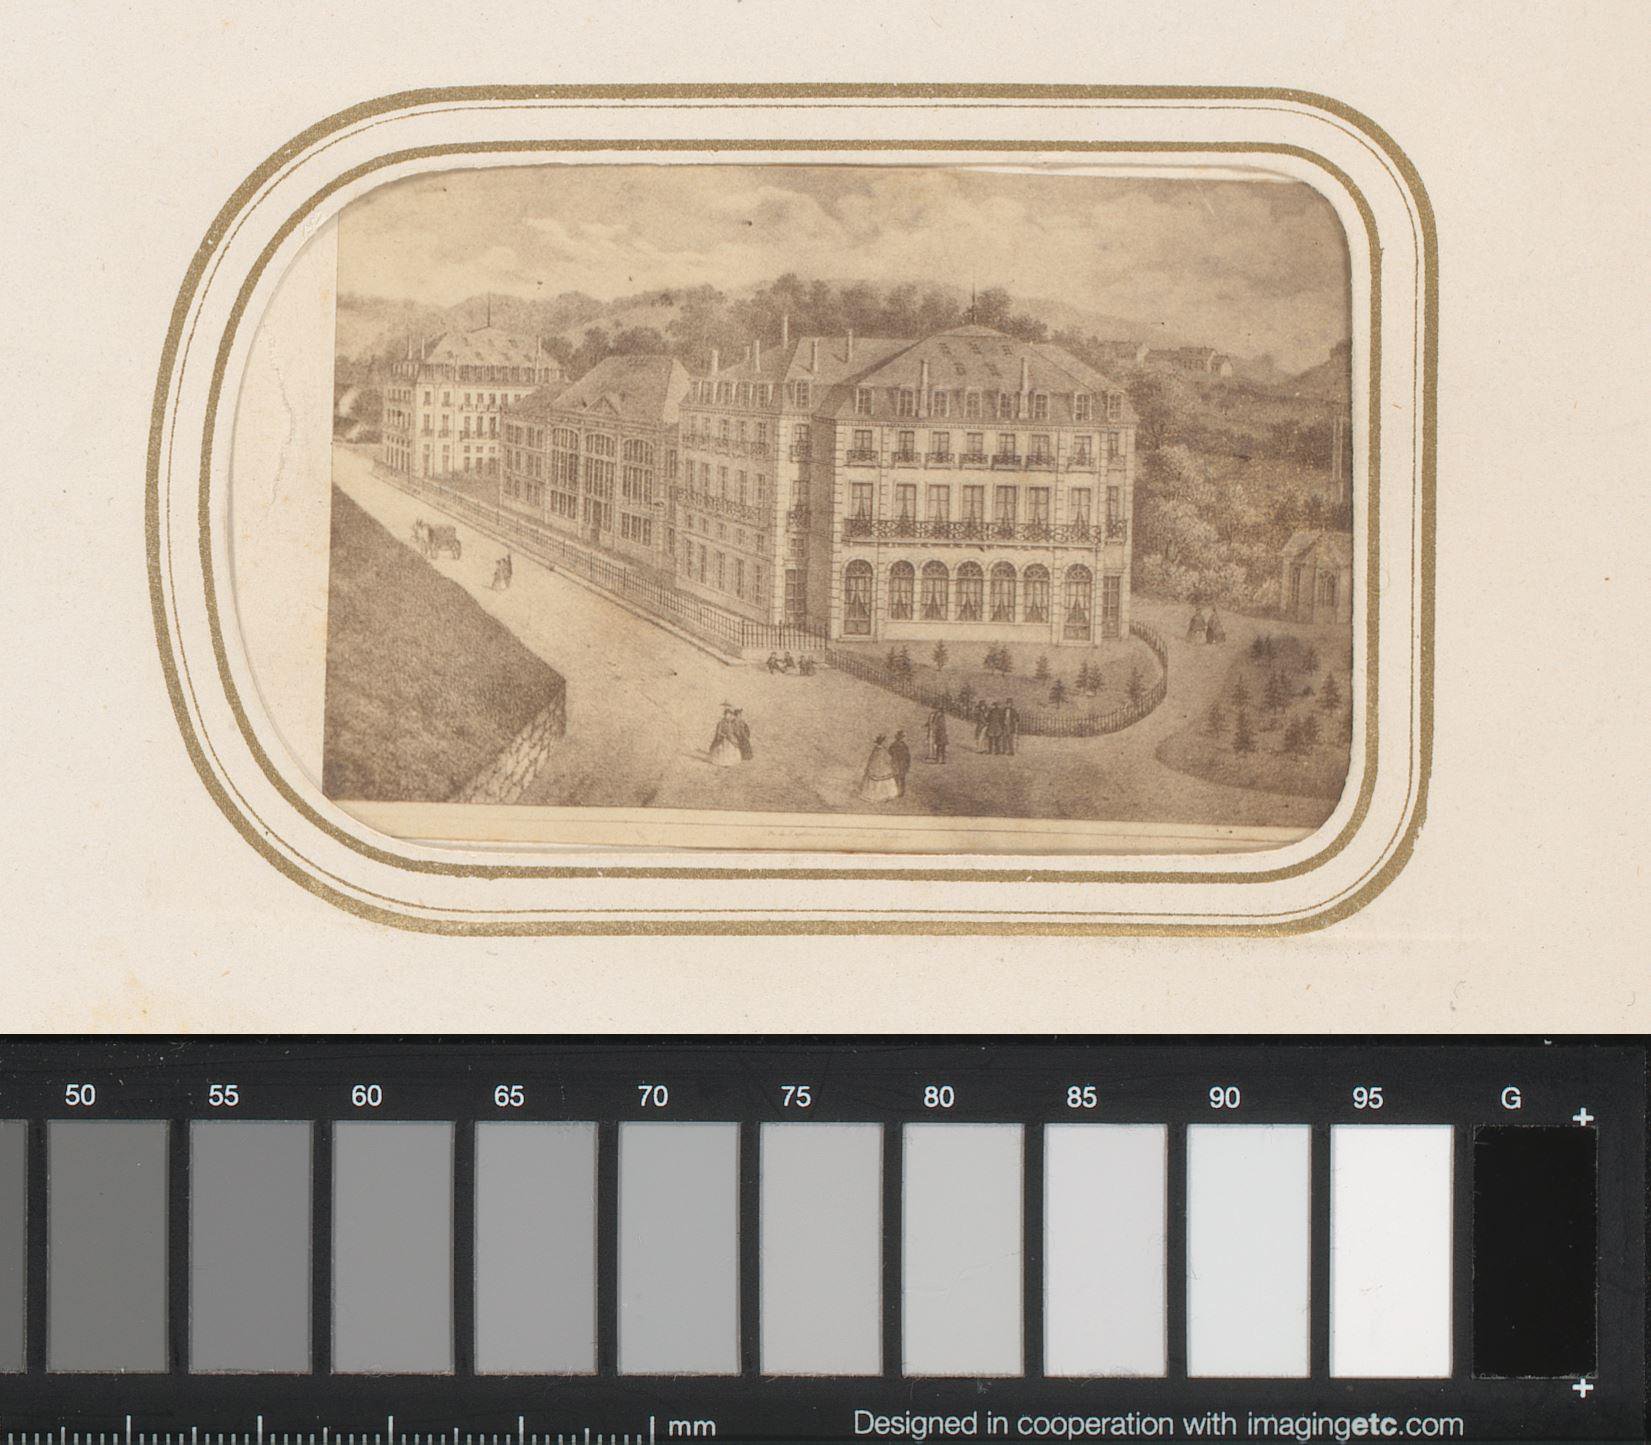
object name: album leaf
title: Fotoreproductie van een prent van een stadsgezicht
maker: charles scherrer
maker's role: fotograaf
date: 1850-1890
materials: cardboard, photographic support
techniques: albumen print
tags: city-view in general; 'veduta', civic architecture; edifices; dwellings, street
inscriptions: inscription: ‘Exporsition Universelle/ Dessins Industriels/ Charles Scherrer/ Photographe’